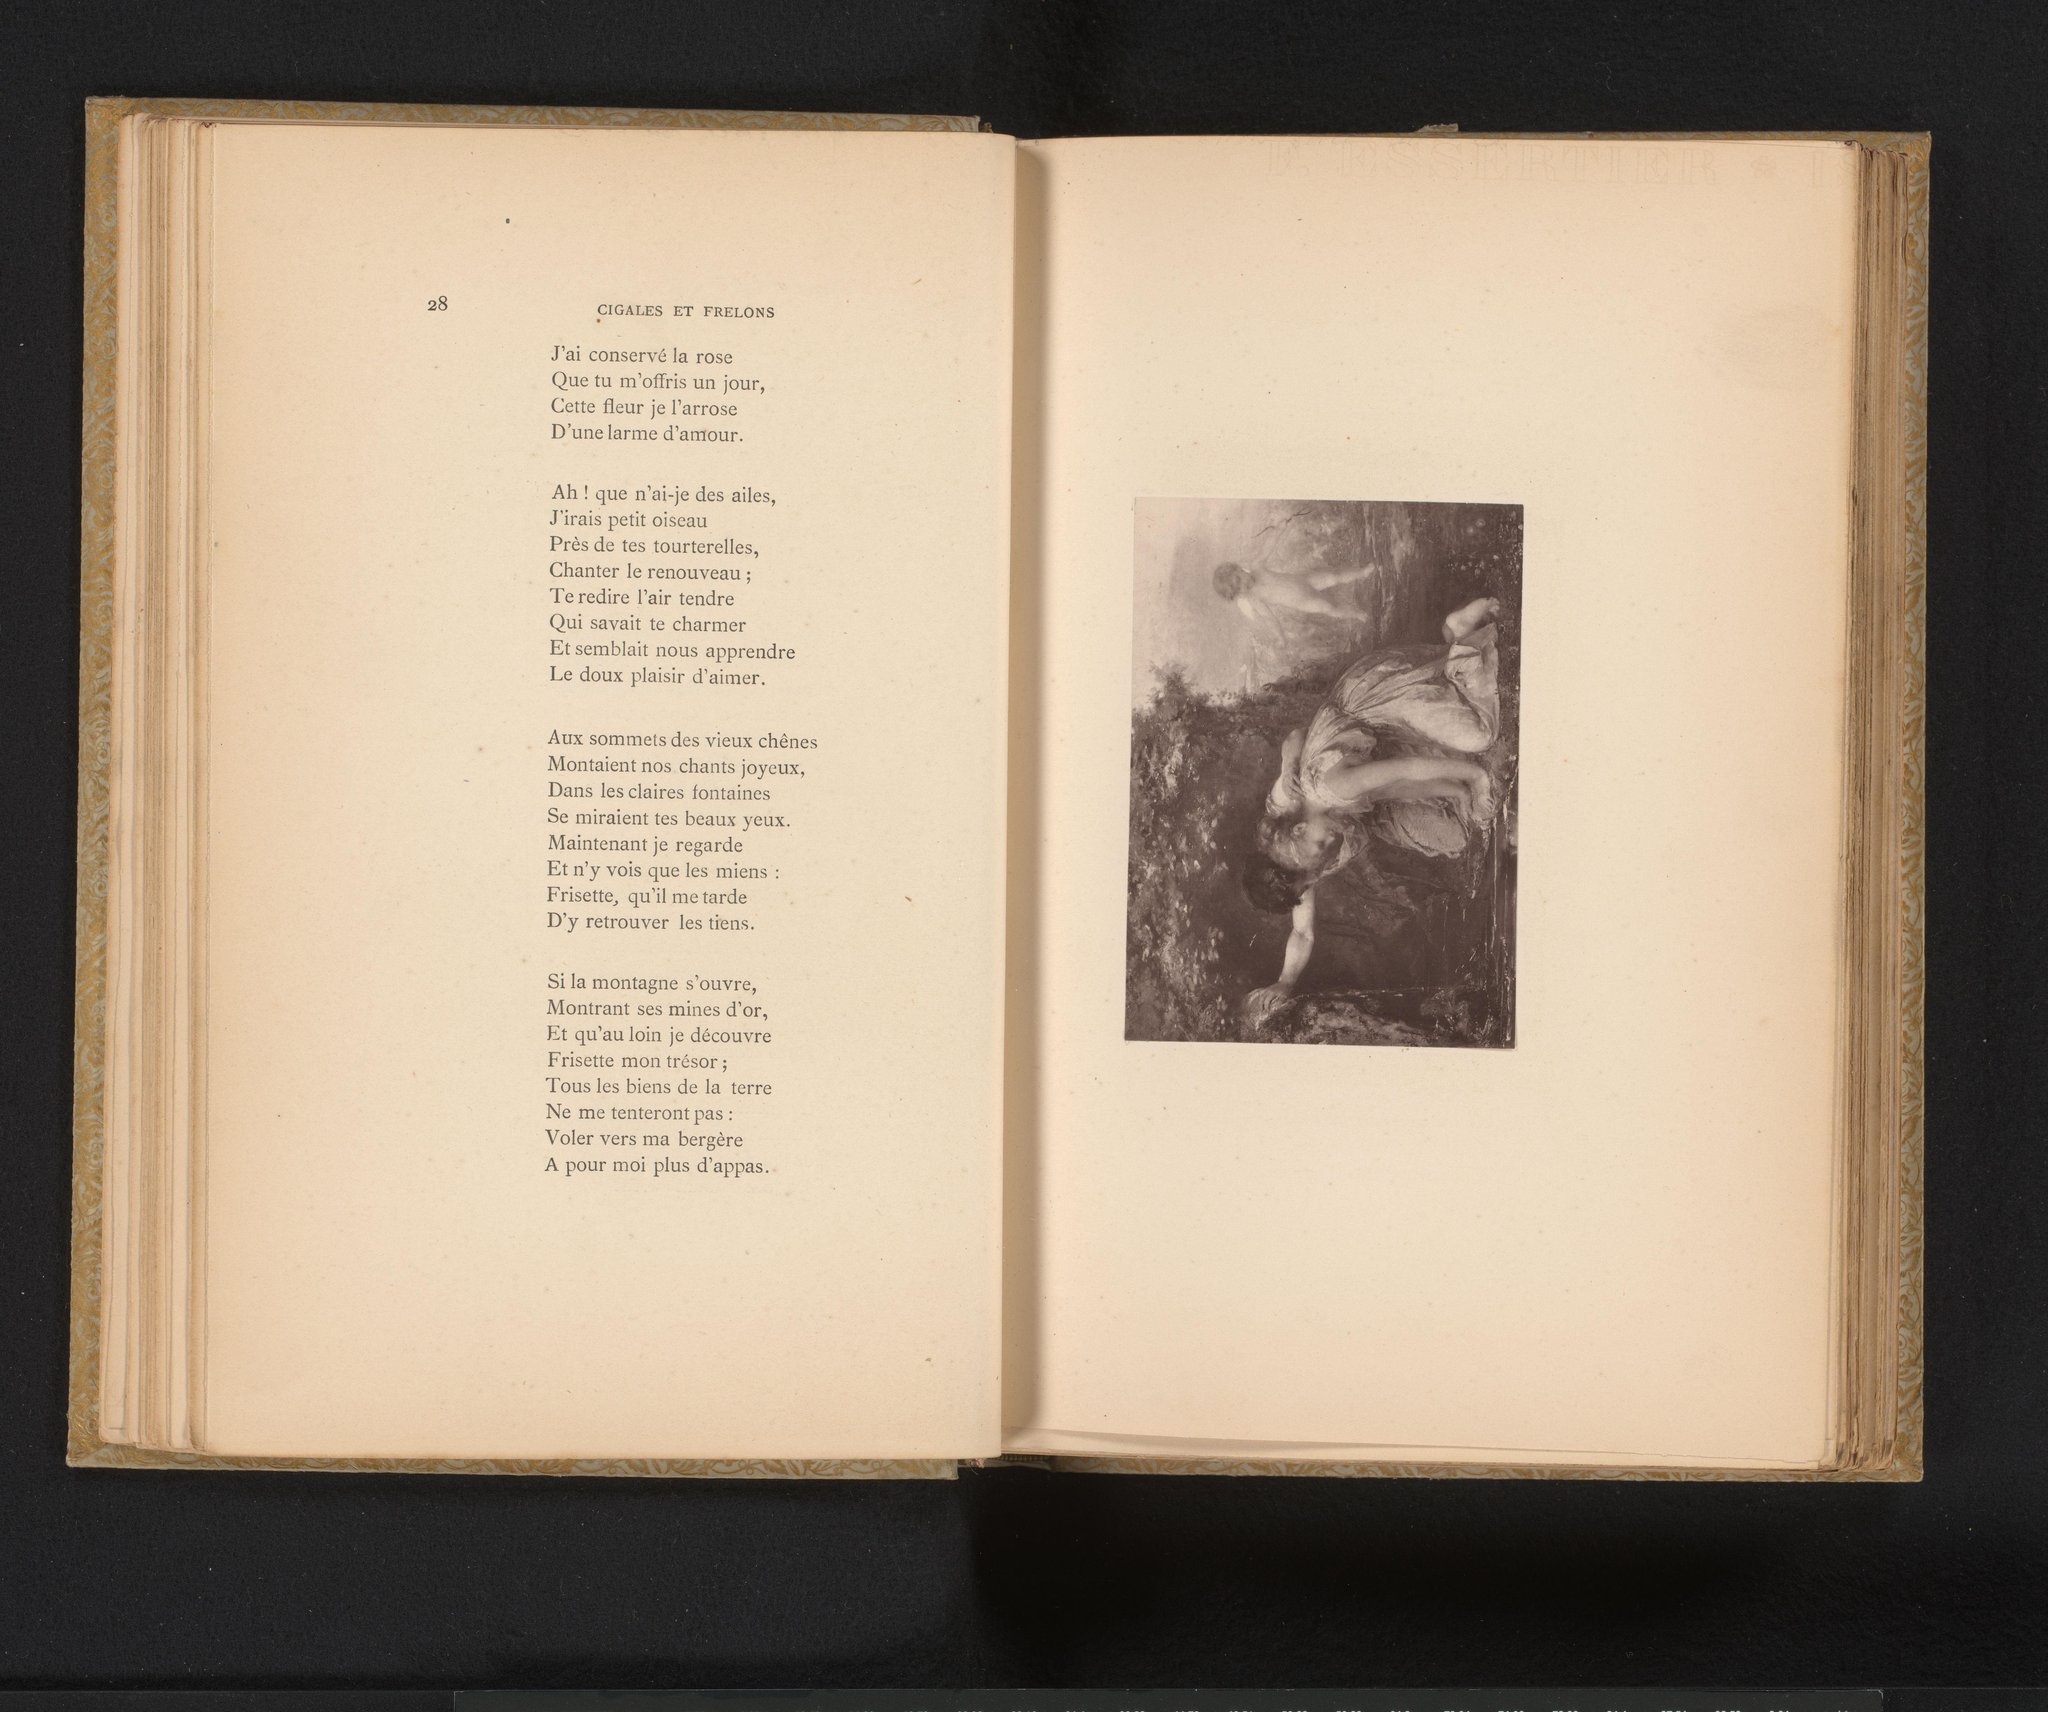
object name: page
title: Fotoreproductie van een schilderij van twee meisjes die naar hun spiegelbeeld kijken in een plas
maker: Anonymous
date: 1874-1884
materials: paper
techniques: albumen print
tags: looking in the mirror; (possibly: contemplation of own beauty - aa - (for) women), pool, puddle, picture, painting